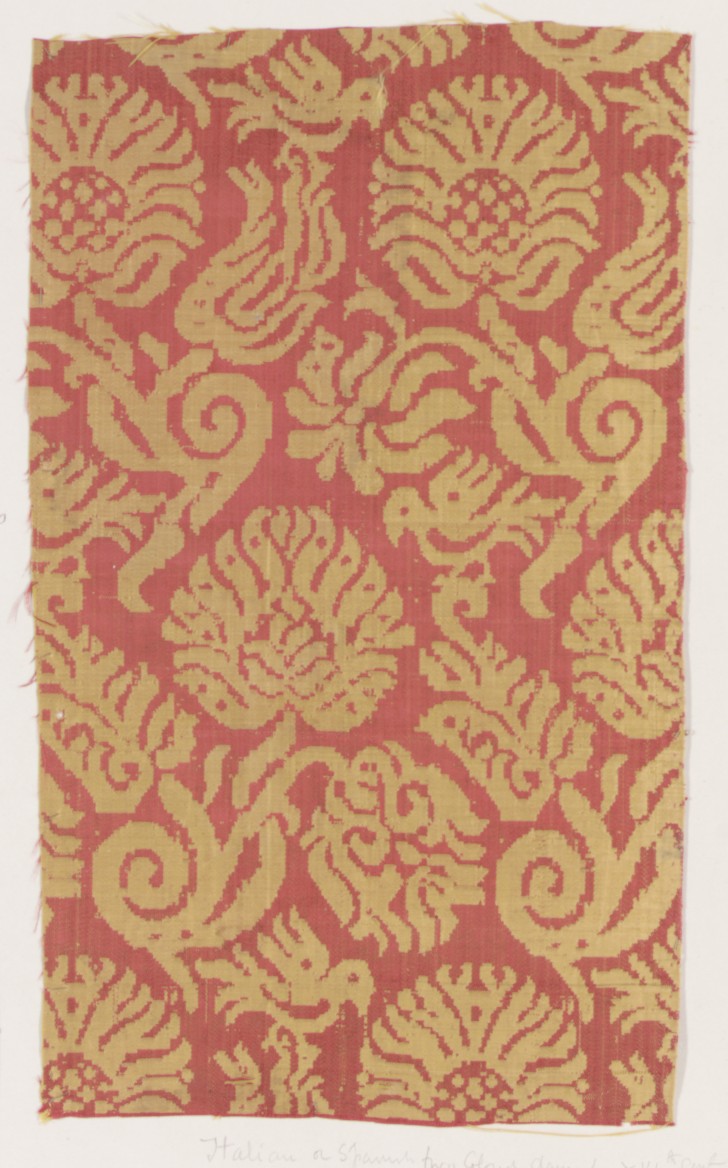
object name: fragment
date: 1501-1600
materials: silk